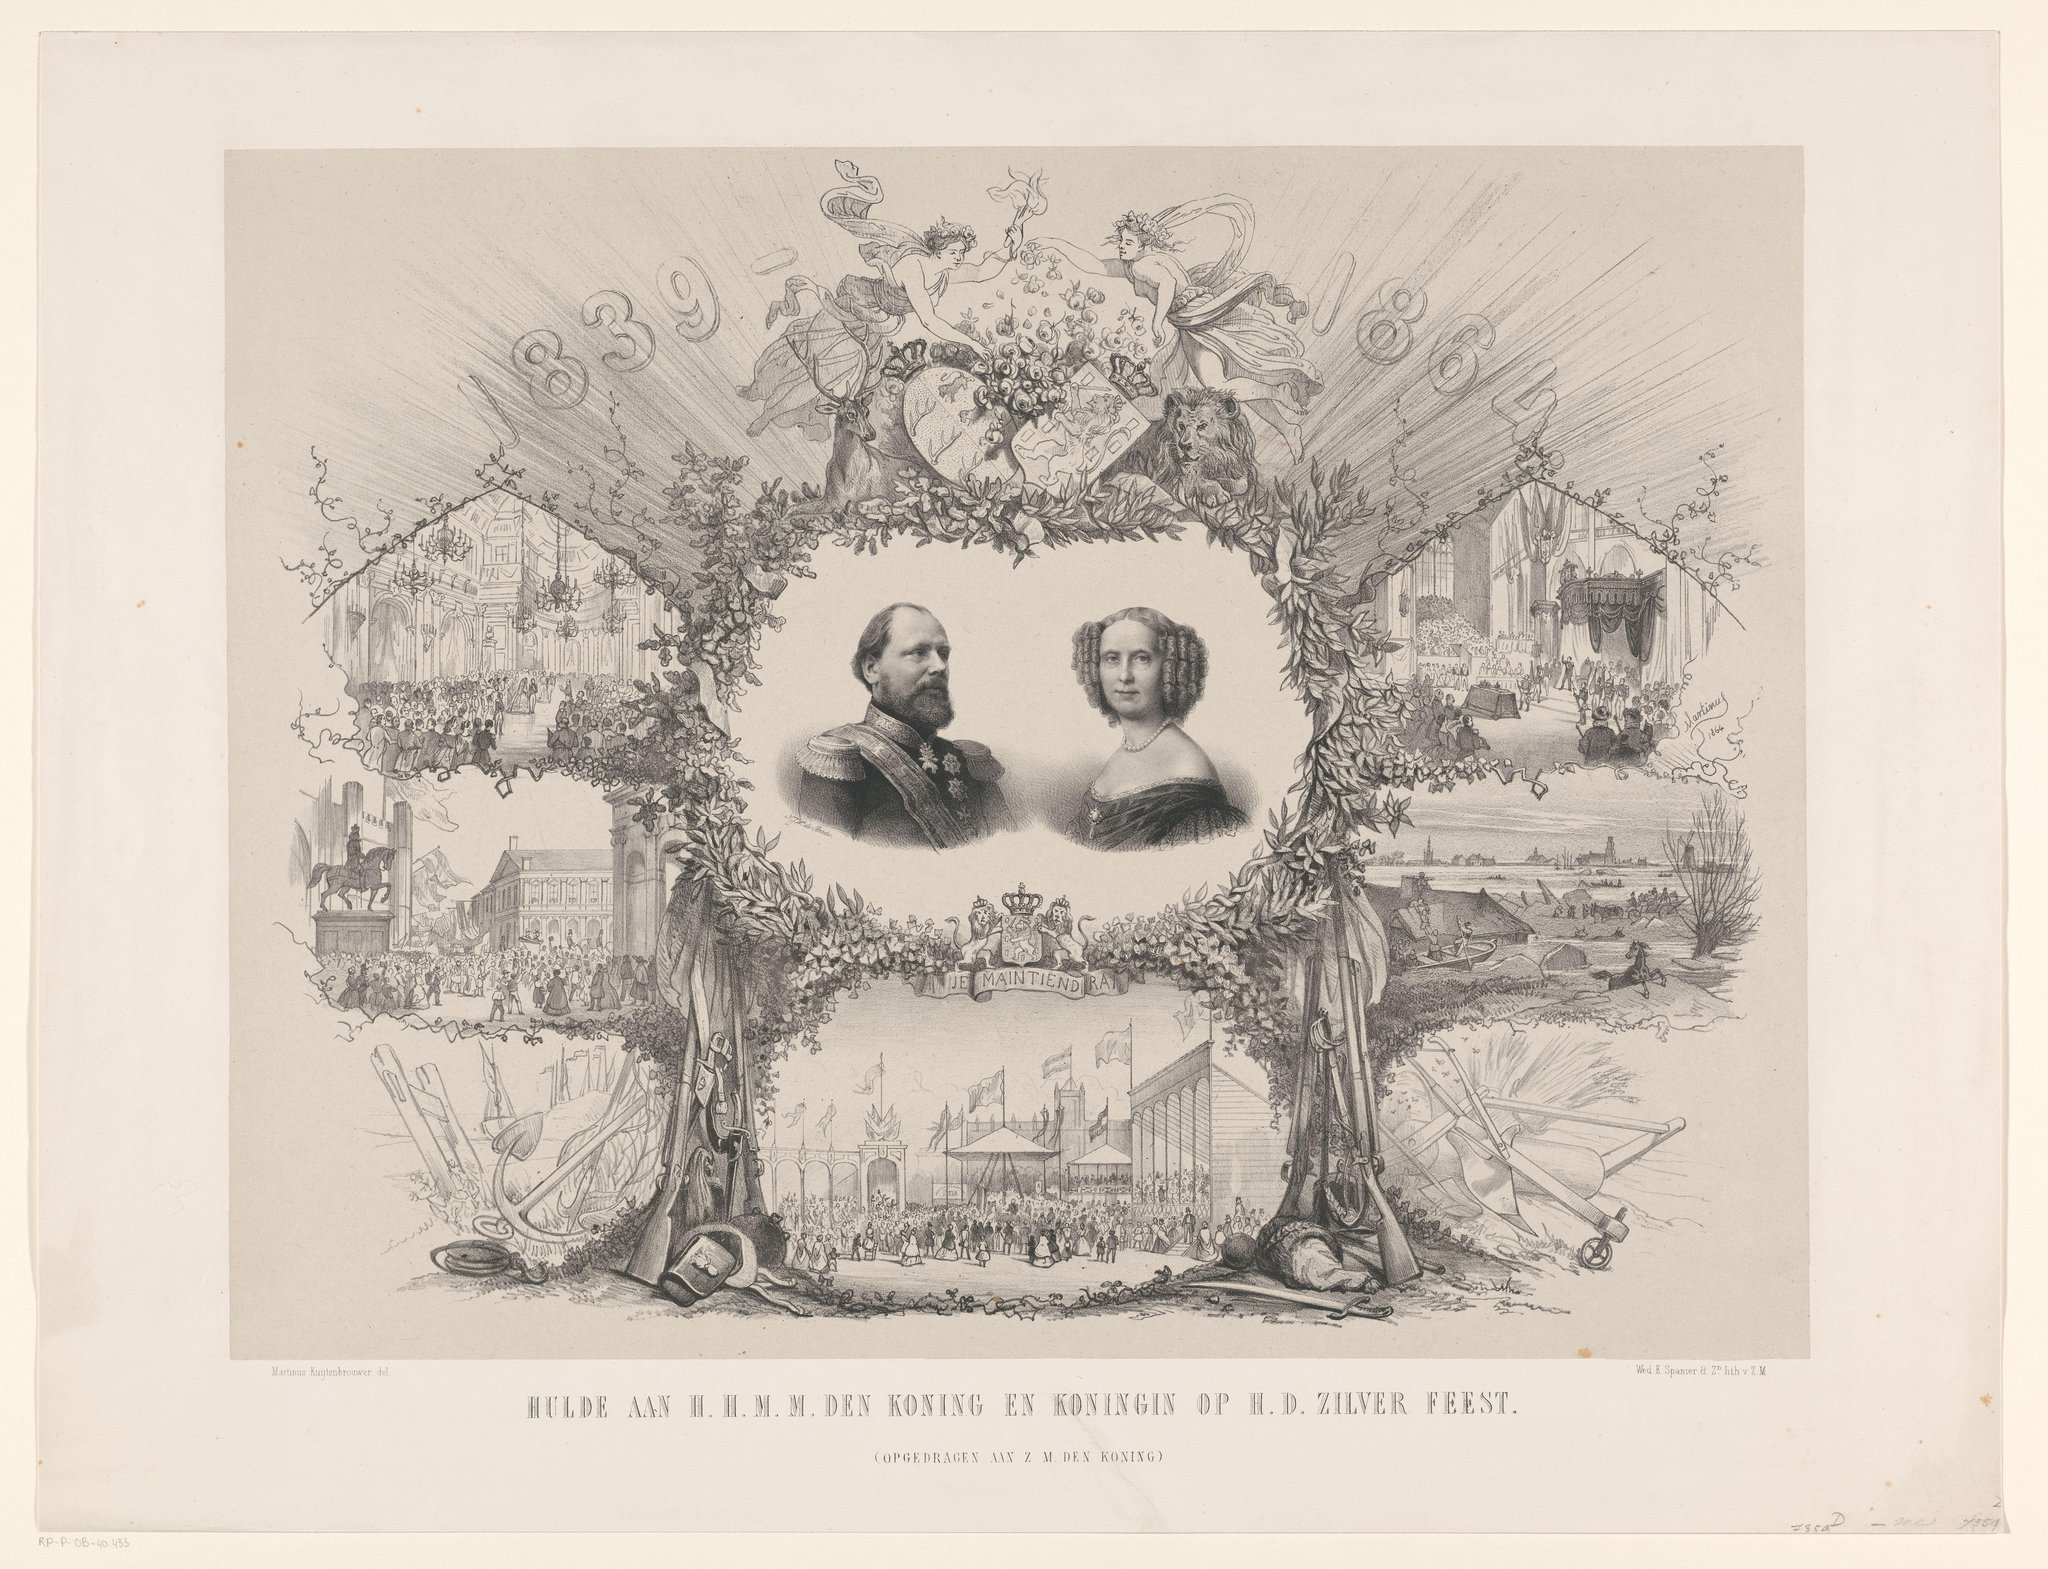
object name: print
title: Hulde aan H.H.M.M. den Koning en Koningin op H.D. Zilver Feest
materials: paper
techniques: lithograph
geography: the hague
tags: willem iii (koning der nederlanden), sophia frederika mathilda van württemberg, silver anniversary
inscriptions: collector's mark: Lugt 2228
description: Gedenkblad ter gelegenheid van het zilveren huwelijk van koning Willem I en koningin Sophie van Württemberg, op 18 juni 1864. Centraal de portretten van het paar. Hieromheen voorstellingen van het huwelijk van de prins in 1839, de inhuldiging van de koning in 1849, de watersnood van 1861, het leggen van de eerste steen voor het Nationaal Monument in 1863 en de vestiging van het paar in Den Haag.